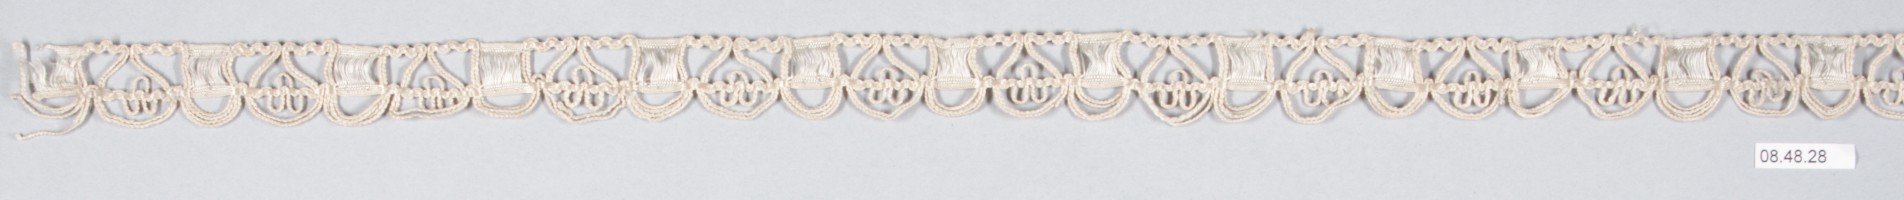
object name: passementerie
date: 1701-1800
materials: silk